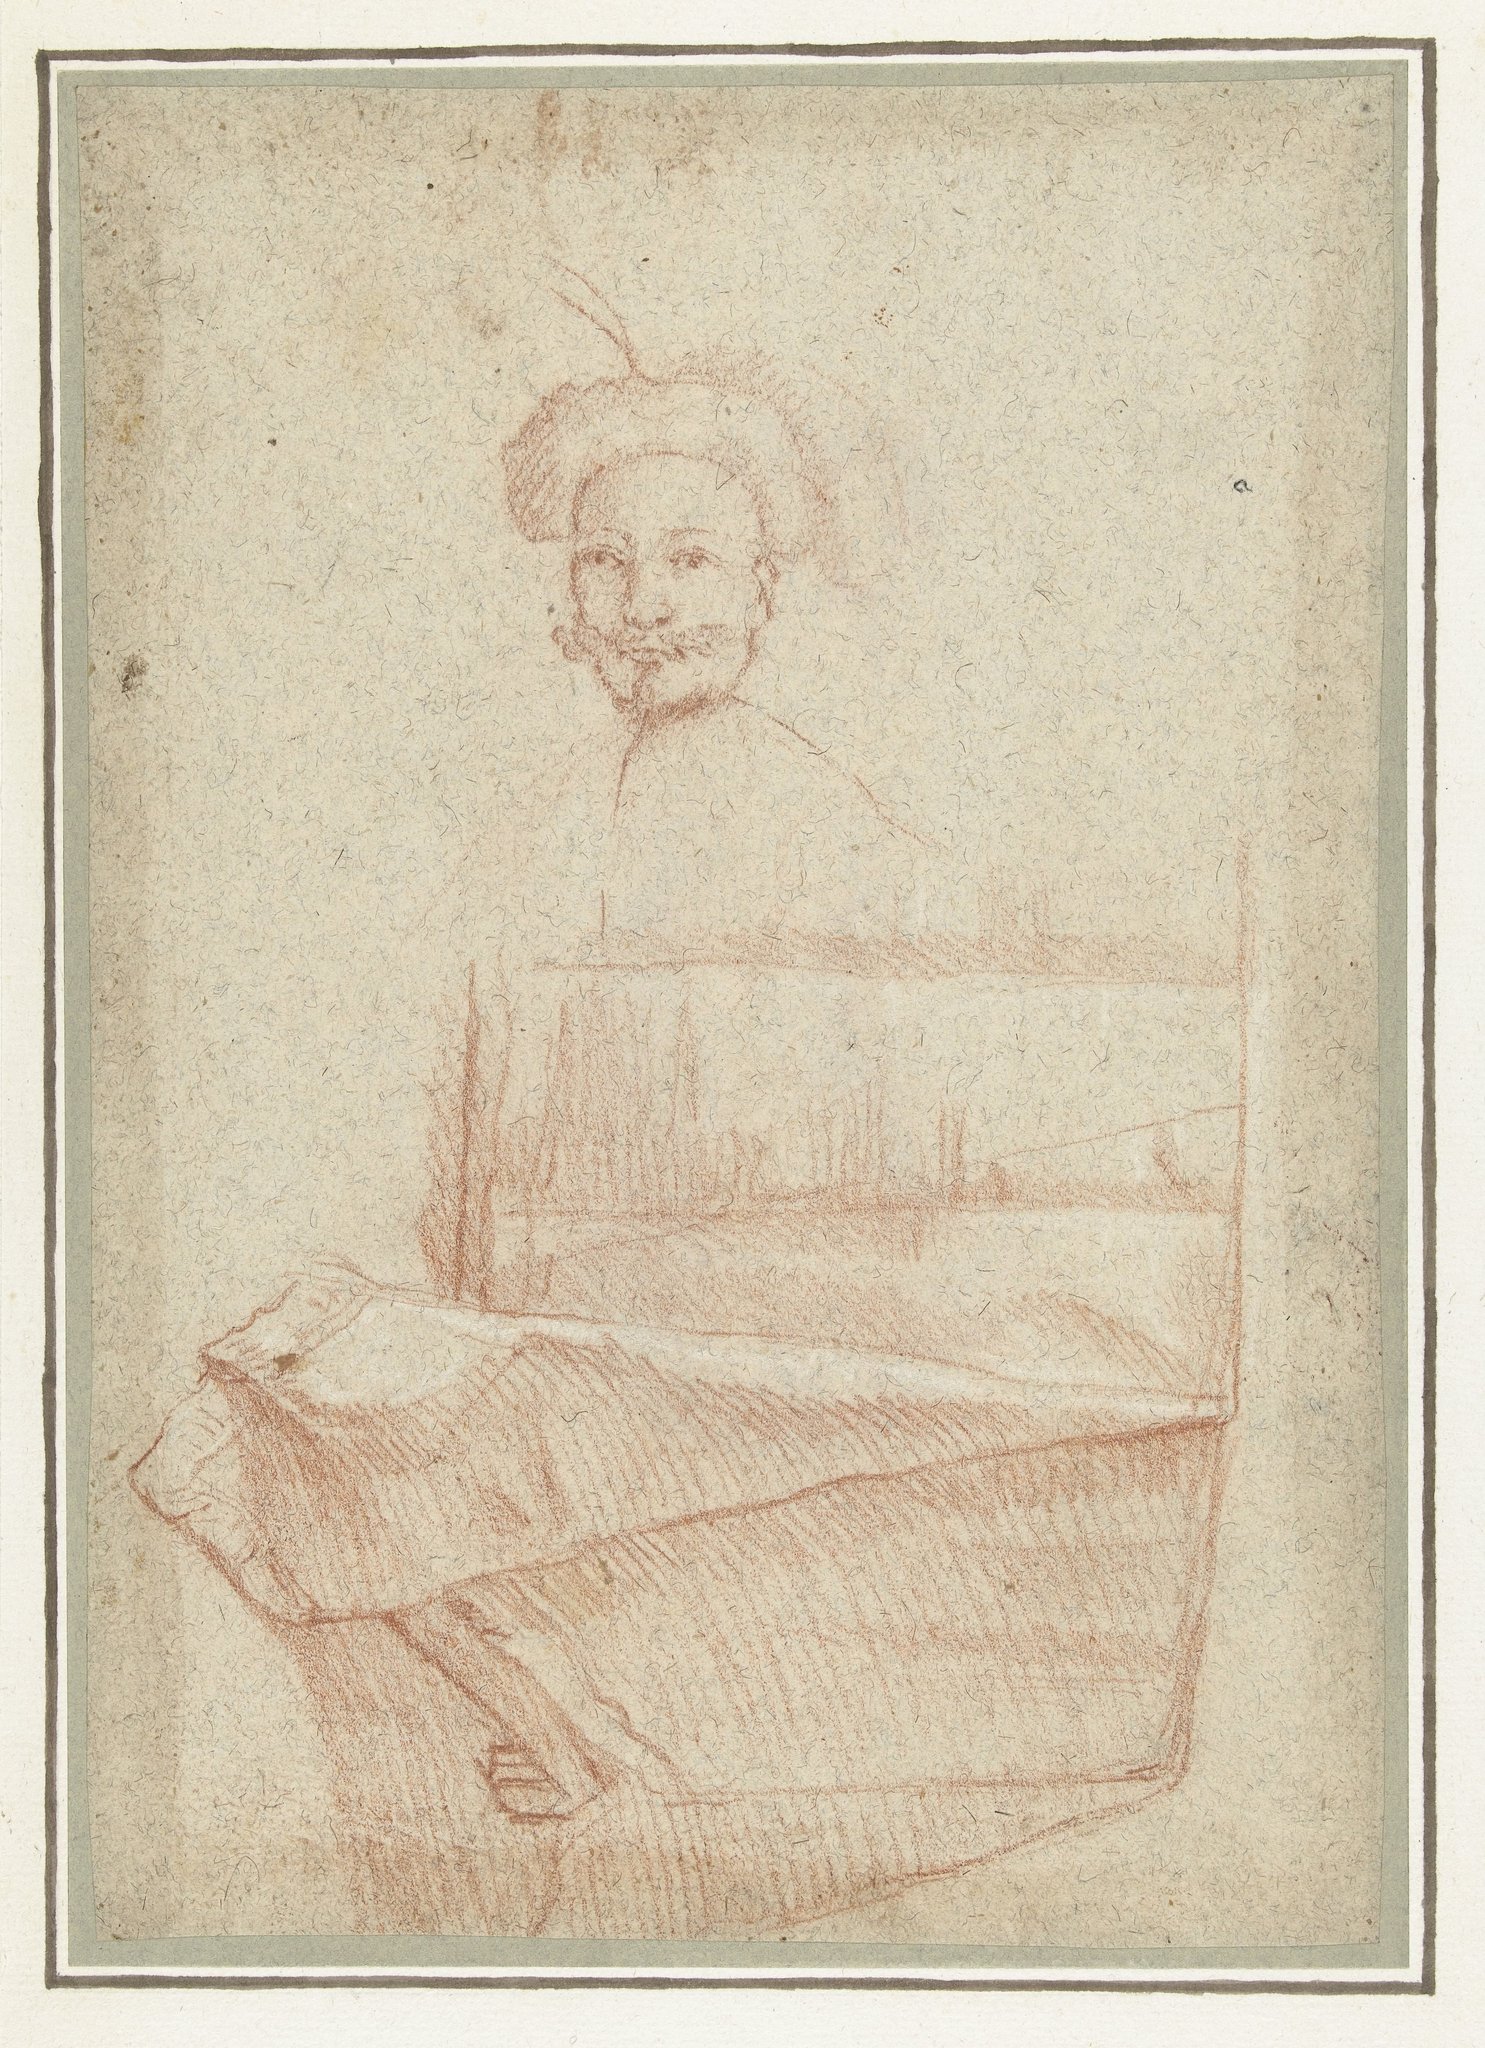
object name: drawing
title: Studies van een manskop en een tafelkleed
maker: domenichino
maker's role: draughtsman, painter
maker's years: 1581-1641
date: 1591-1641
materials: chalk, paper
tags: head (human), female sex; woman, prophetic dream, cover for table, etc.